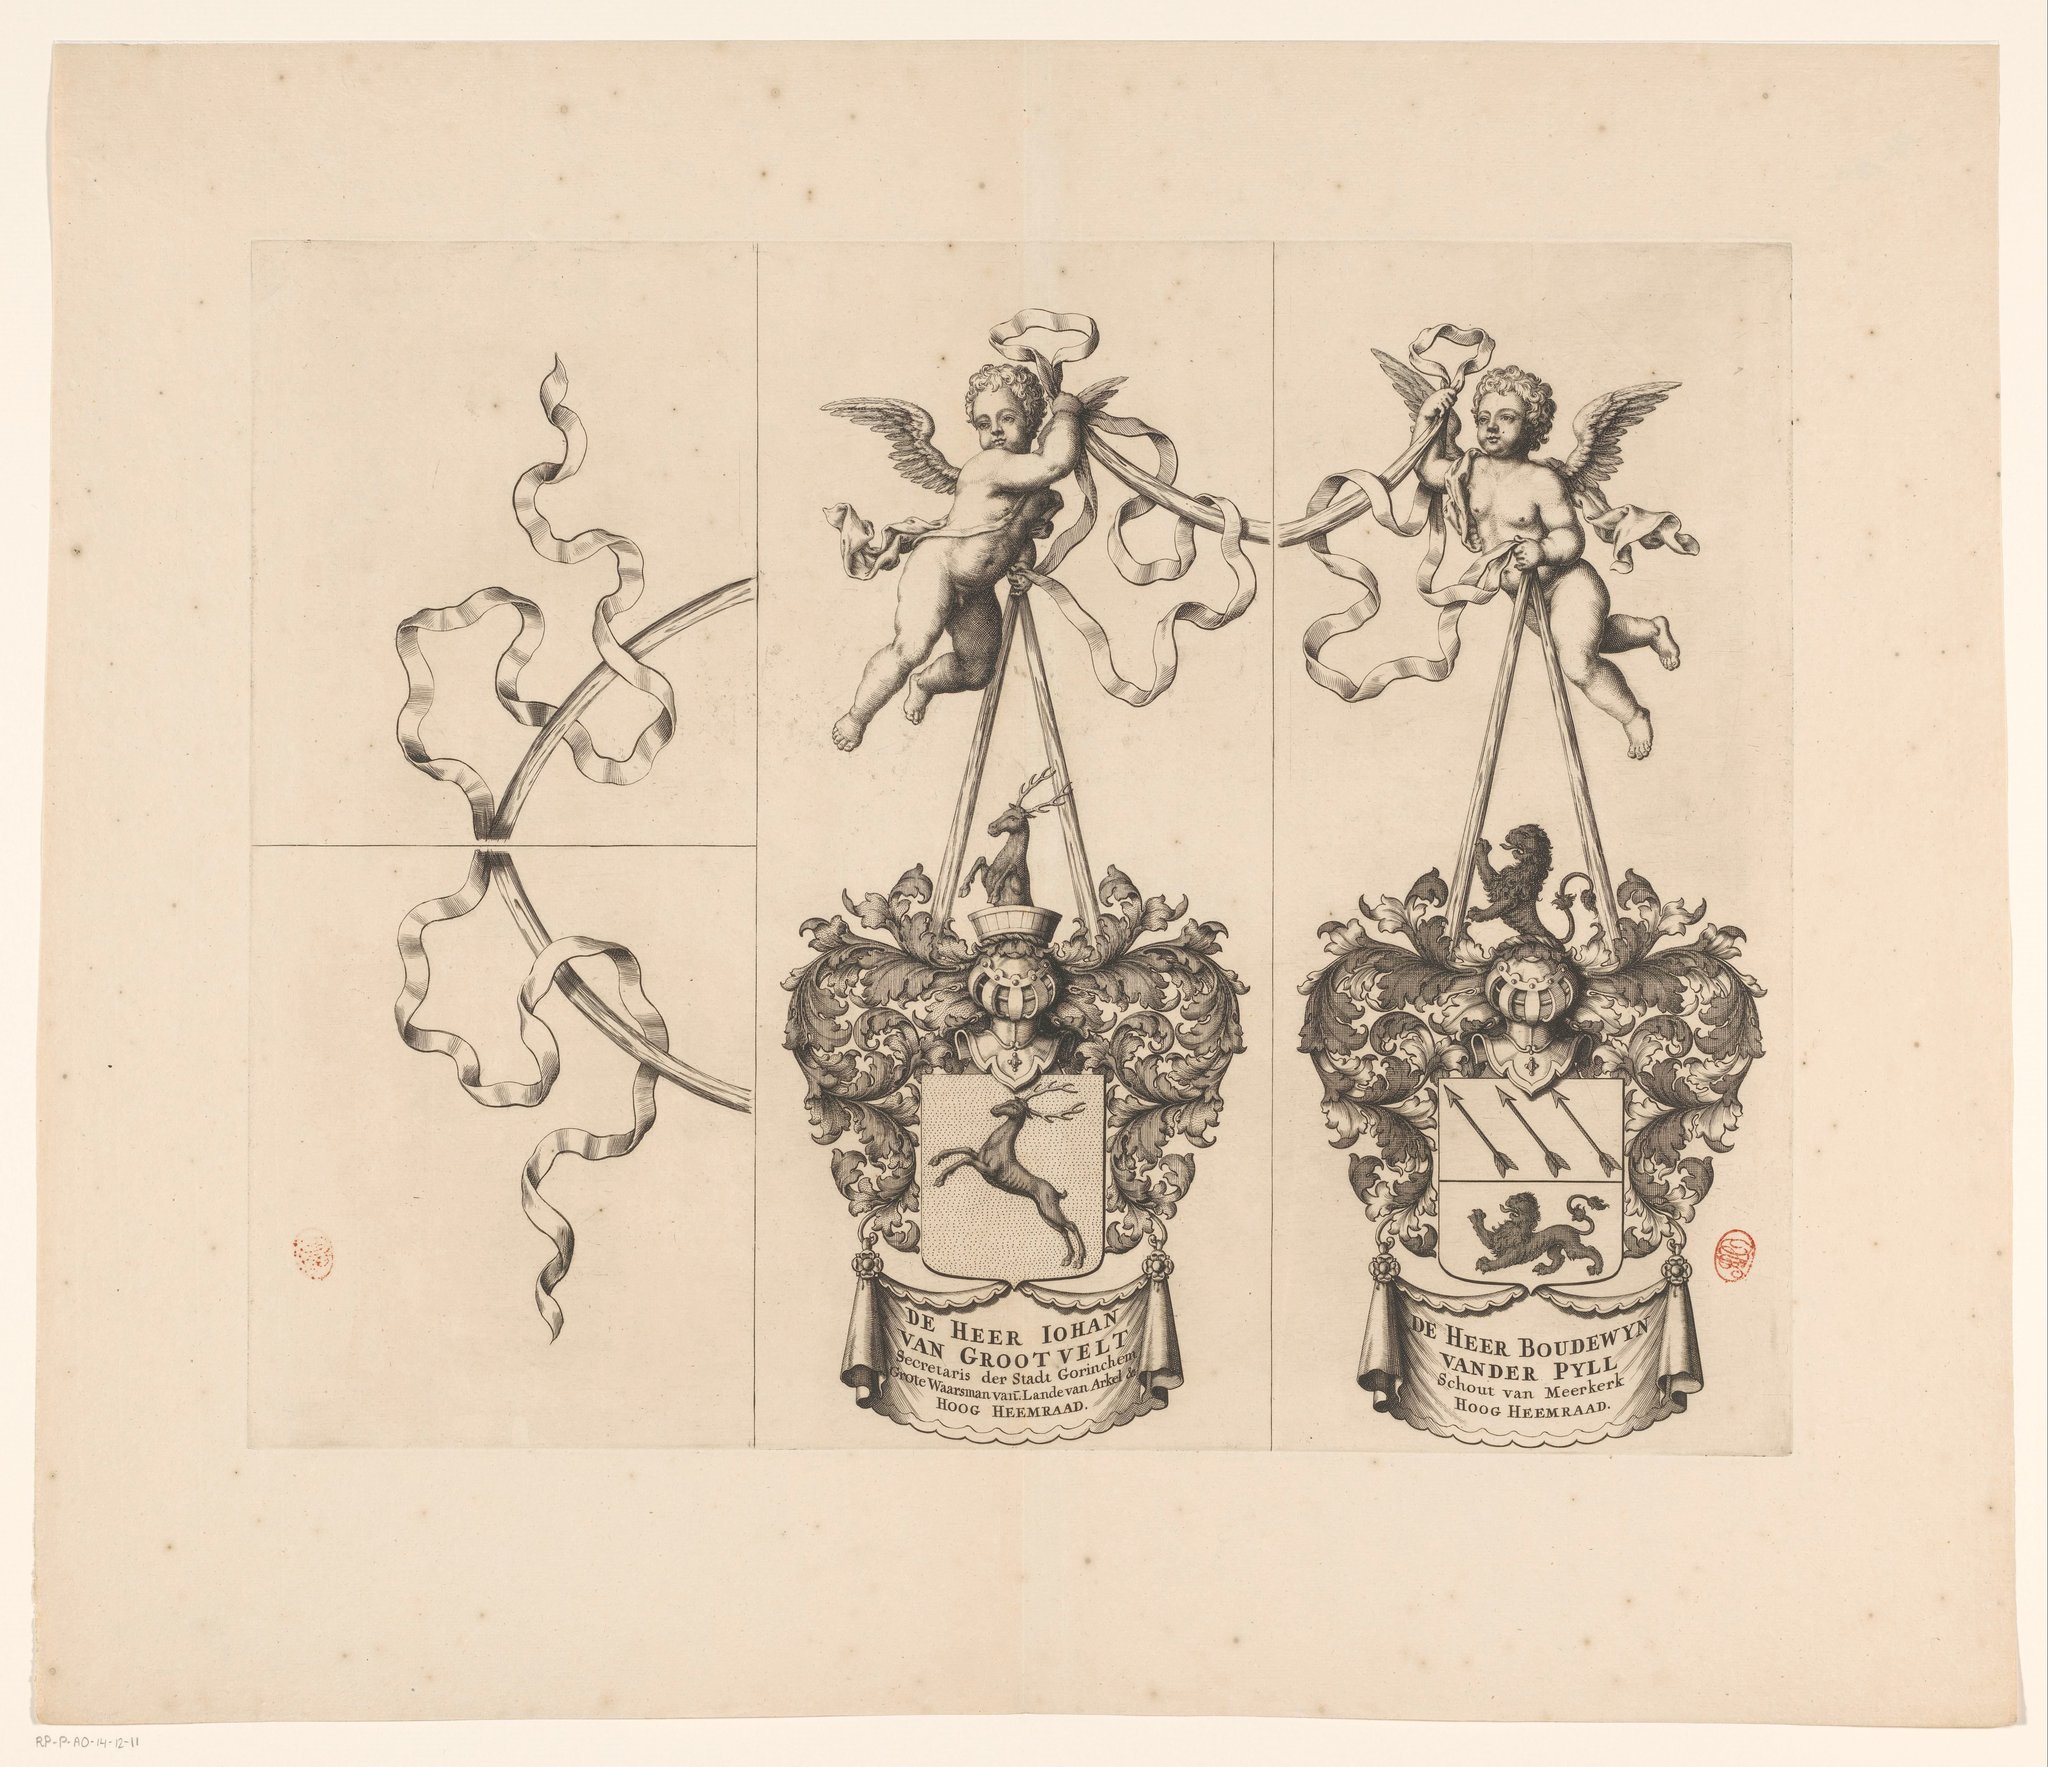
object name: print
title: Den Alblasser Waard en Vyf Heeren Landen, te samen groot 33110. mergen / Nieuwe caerte vertoonende den geheelen Alblasserwaert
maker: Anonymous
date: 1716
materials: paper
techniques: engraving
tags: armorial bearing, heraldry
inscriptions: collector's mark: Lugt 195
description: Deze prent is onderdeel van de wapenrand van de tweede druk (1716) van 'Den Alblasser Waard en Vyf Heeren Landen, te samen groot 33110. mergen / Nieuwe caerte vertoonende den geheelen Alblasserwaert', een vierdelige kaart van de Alblasserwaard en de Vijfheerenlanden (zie RP-P-AO-14-12). Van deze kaart zijn voor zover na te gaan vijf verschillende drukken bekend, uit respectievelijk 1681, 1716, 1730, 1741 en 1767. De kaart zelf is gedrukt van vier platen. In eerste instantie werden de wapens van de dijkgraaf, hoogheemraden en penningmeester/secretaris op de platen van de kaart gegraveerd. Voor de druk van 1716 werden deze wapenschilden van de platen afgesneden, werden de platen bijgewerkt en werd een aparte sierrand met de wapenschilden gemaakt. Voor de daaropvolgende drukken zou de wapenrand telkens aangepast en/of vernieuwd worden naar samenstelling van het bestuur van het hoogheemraadschap (waarschijnlijk werd de kaart telkens als een nieuwe dijkgraaf aantrad opnieuw uitgegeven met bijhorende wapenrand). Omdat er geen gemonteerde versie van de wapenrand bekend is en daarom onduidelijk is hoe deze er precies uit heeft gezien, is de wapenrand niet virtueel samengevoegd maar zijn de verschillende onderdelen wel te vinden onder RP-P-AO-14-12B.